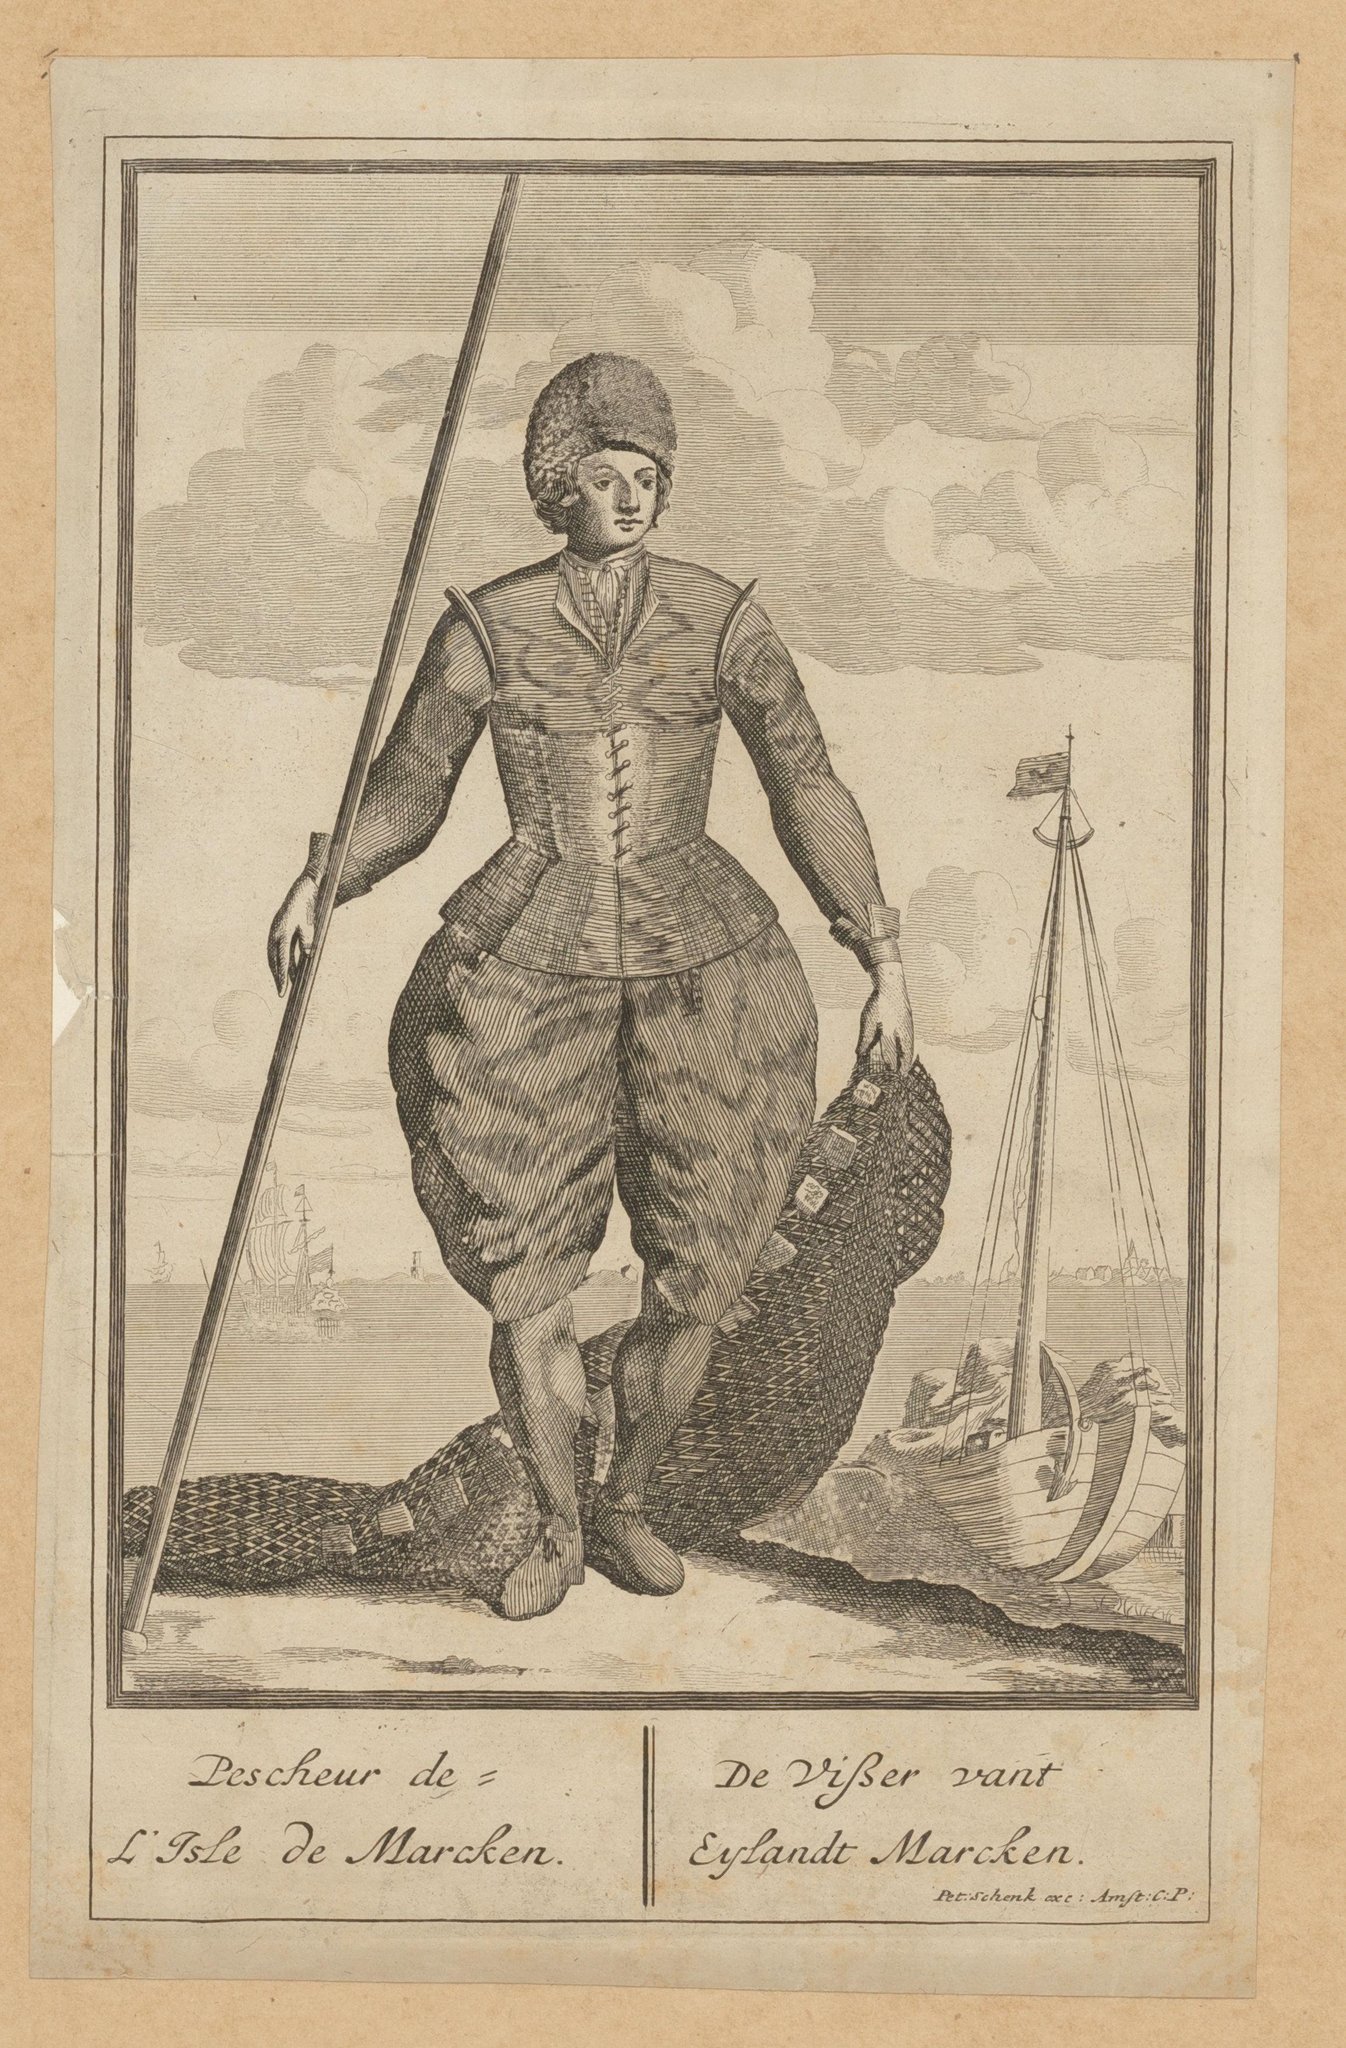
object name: print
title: Nederlandse klederdrachten naar Pieter van den Berge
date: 1689-1713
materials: paper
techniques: engraving, etching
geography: netherlands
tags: sea and coastal fishery (+ men (labourers)), clothes, costume (+ men's clothes), folk costume, regional costume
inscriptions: collector's mark: Lugt 1641, collector's mark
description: Een visser van het eiland Marken. Staande aan de wal met een stok en een visnet in de handen. Ongenummerd. Prent uit een serie prenten naar Pieter van den Berge met dorpelingen die klederdrachten dragen. Onderwerpsrubrieken binnen de Atlas Zeden en Gewoonten: De Kleeding, Volkskleederdracht, Noord-Holland.